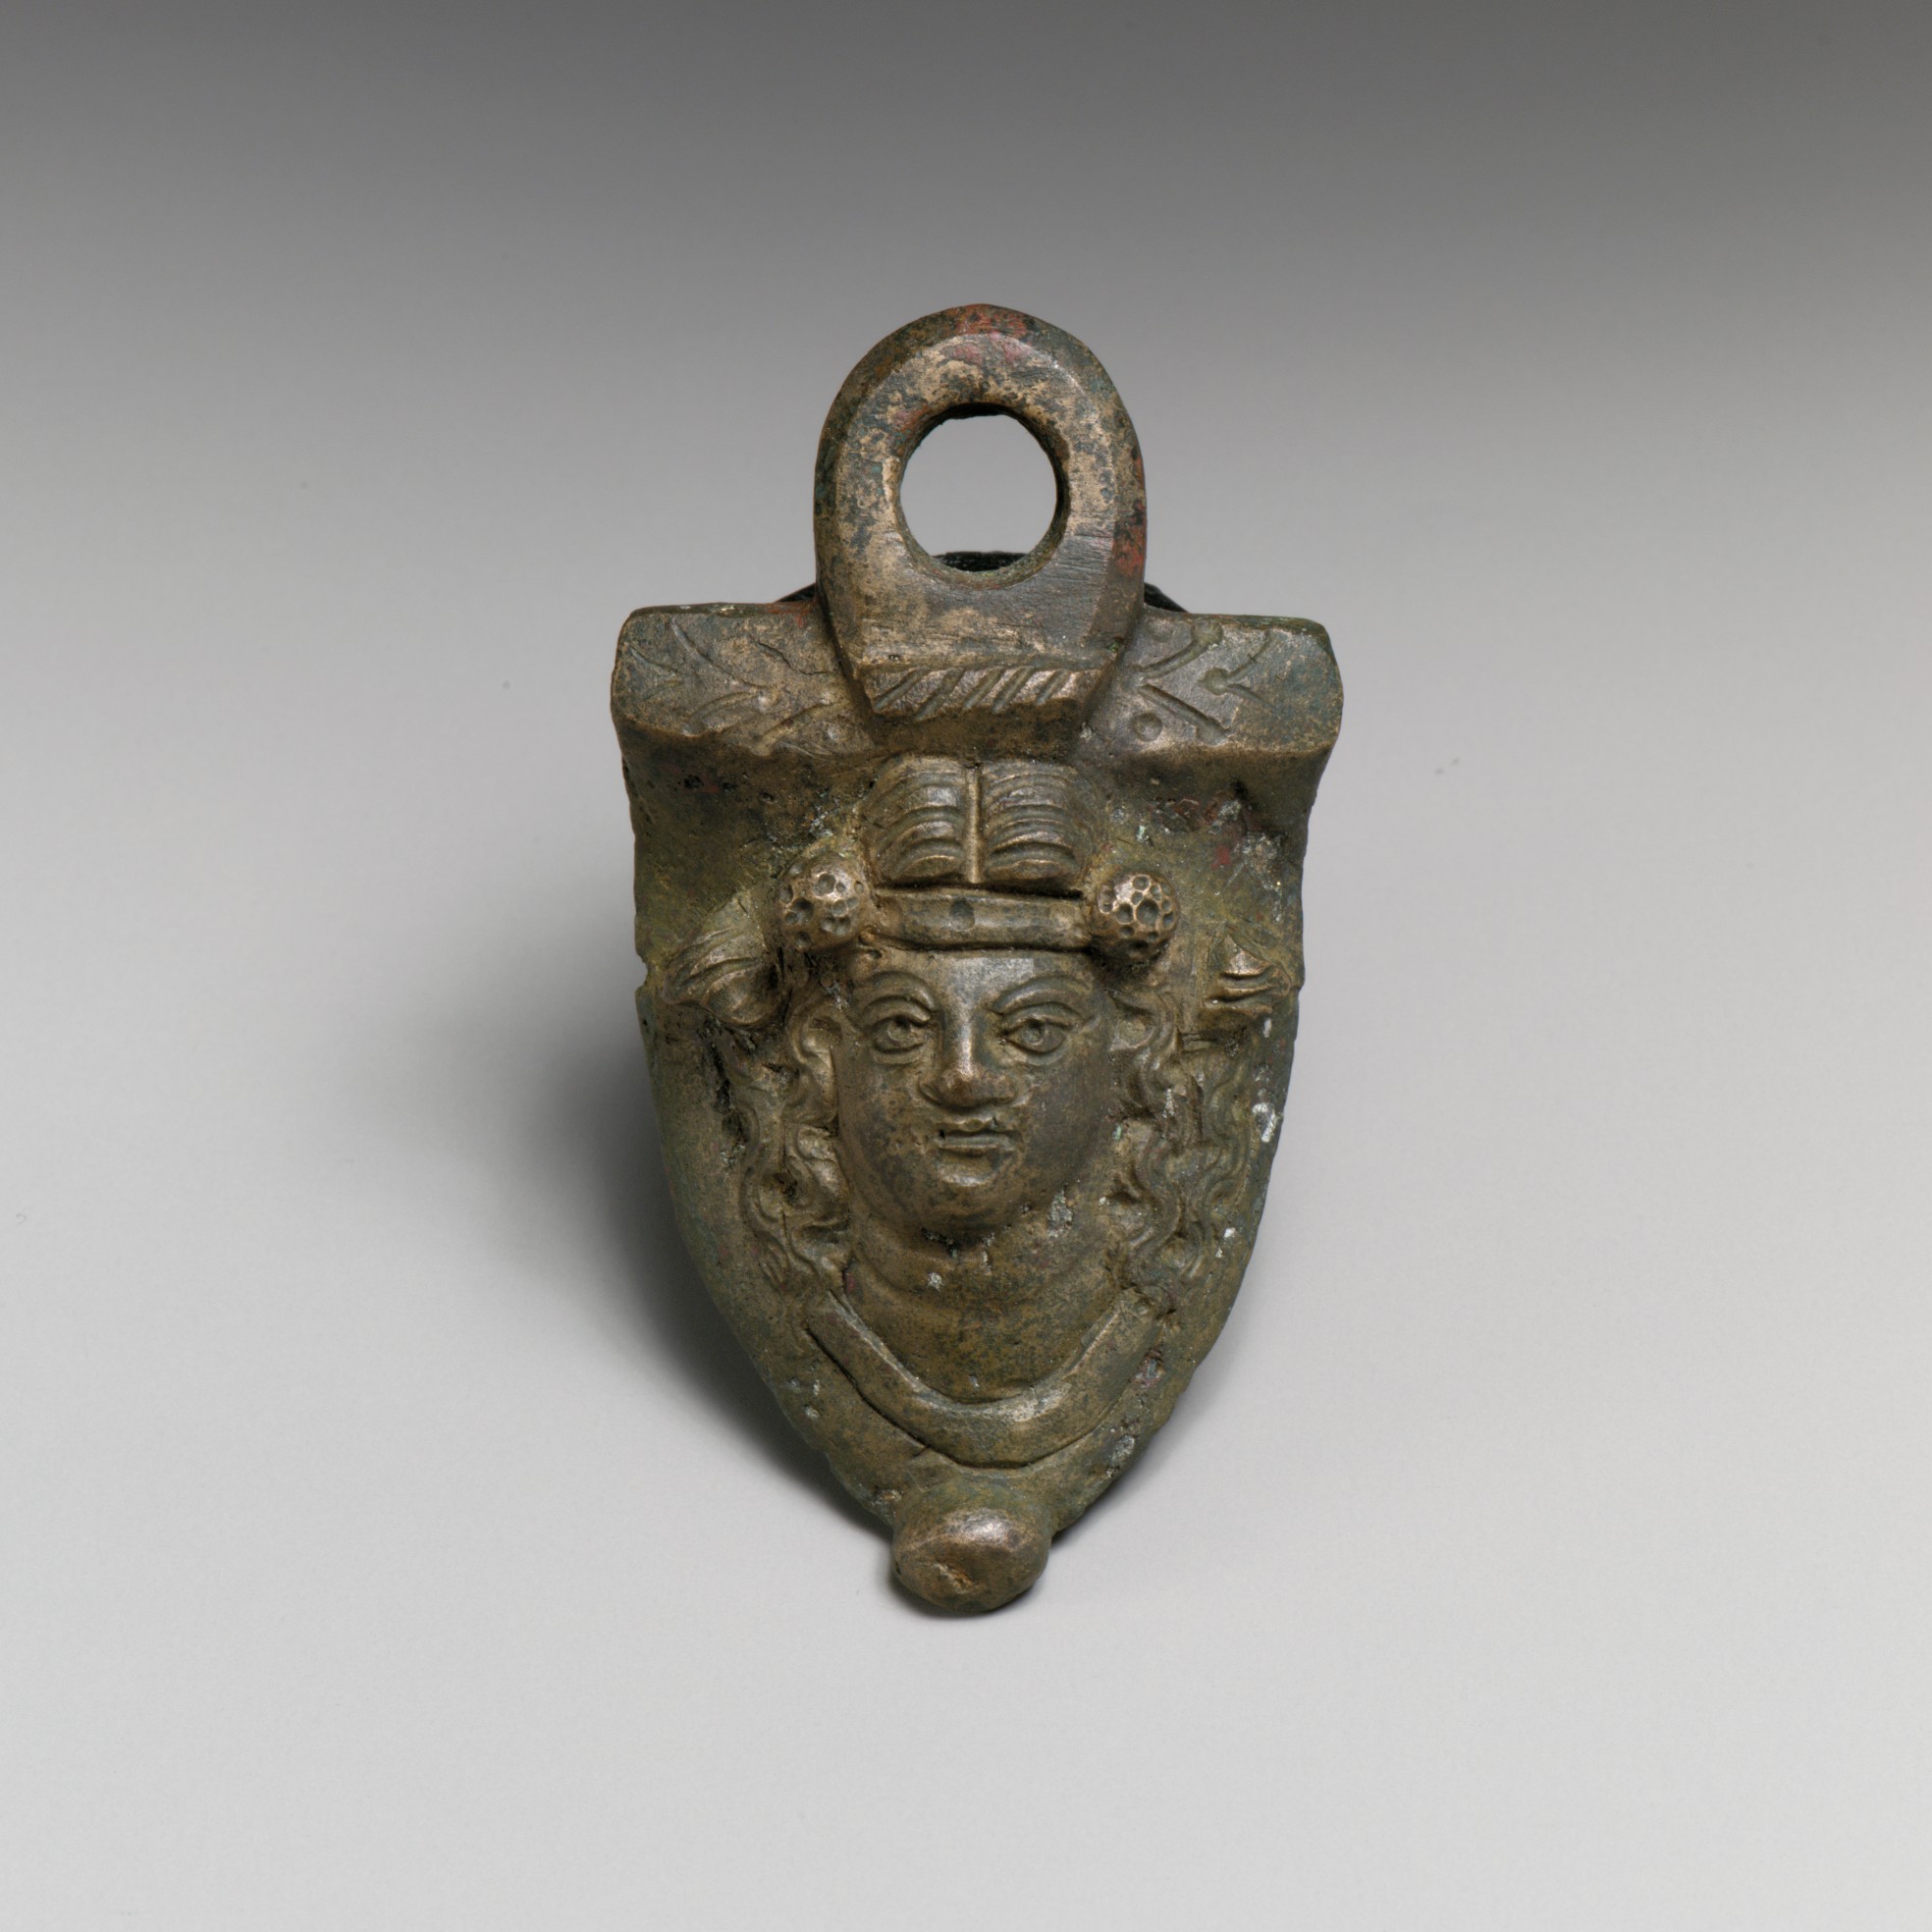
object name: handle of a situla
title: Two bronze handle attachments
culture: roman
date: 101-200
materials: bronze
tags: masks